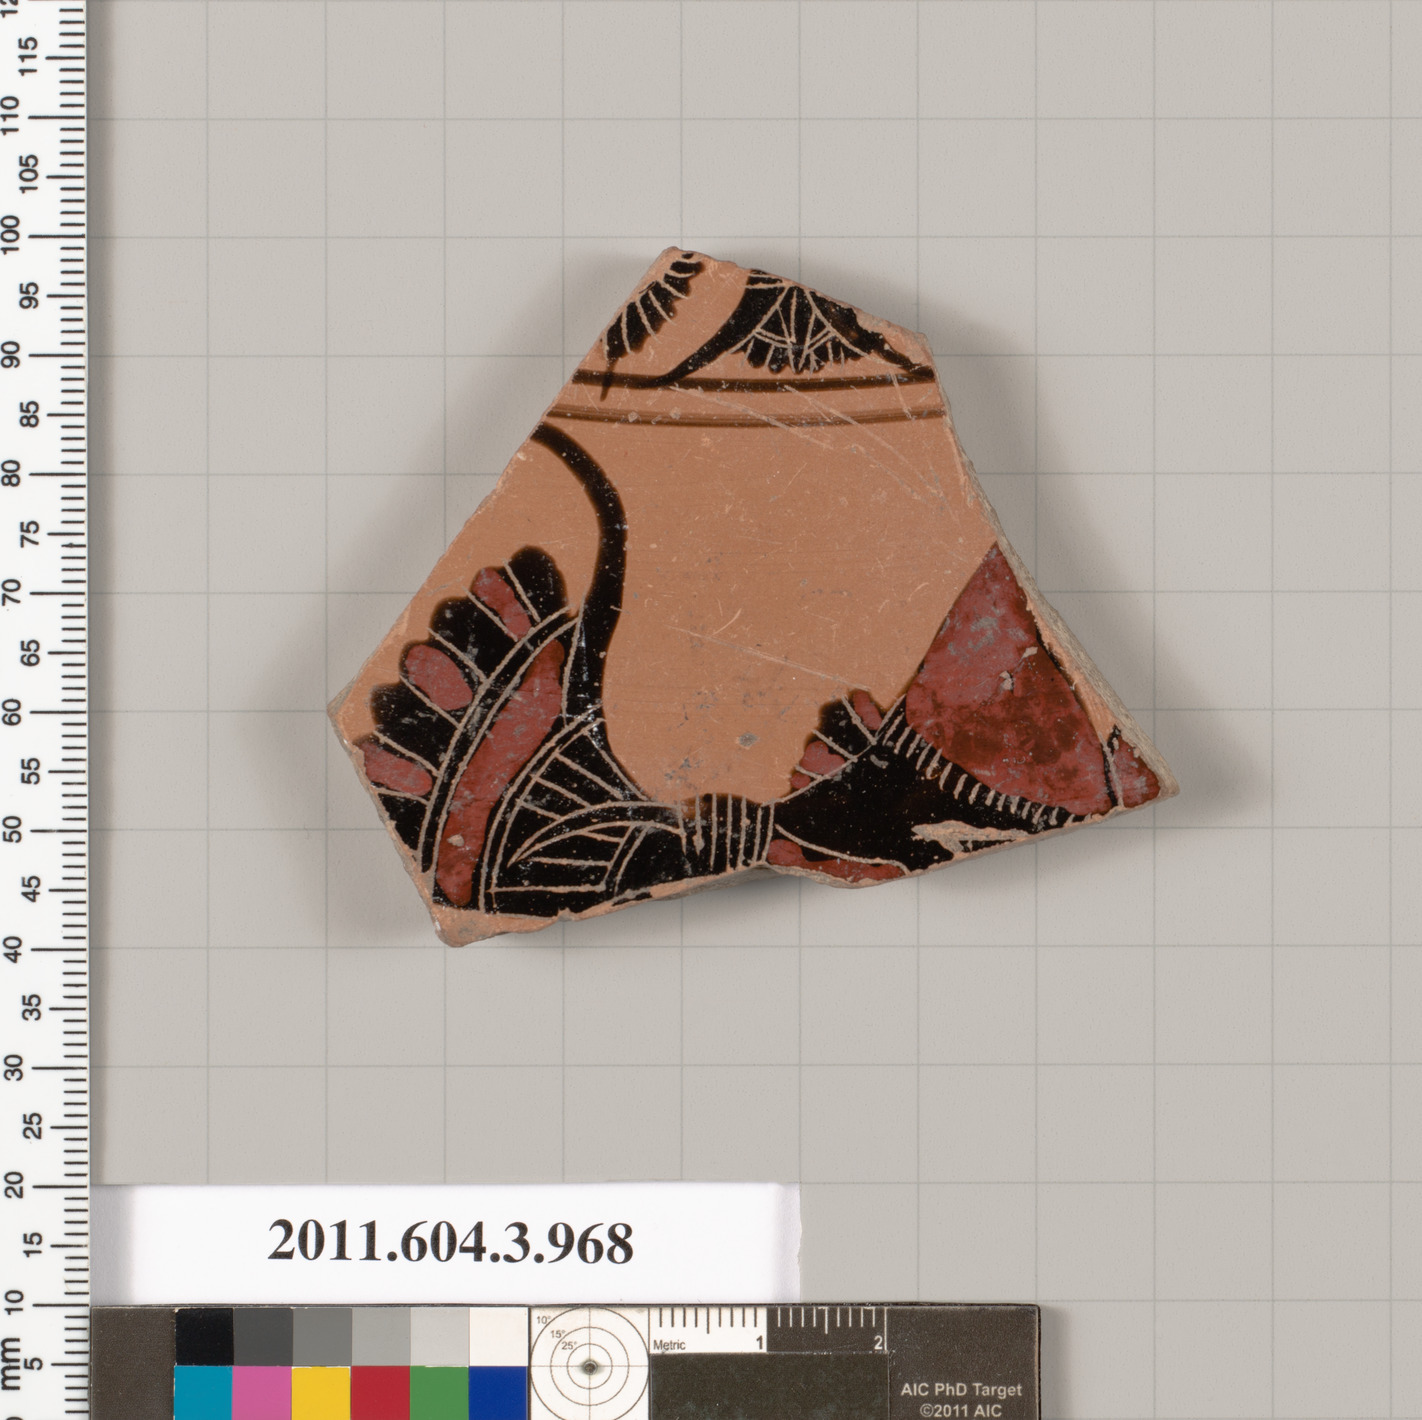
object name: lekanis lid fragment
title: Terracotta fragment of a lekanis lid (covered dish)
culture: greek, attic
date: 575-551 BCE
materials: terracotta